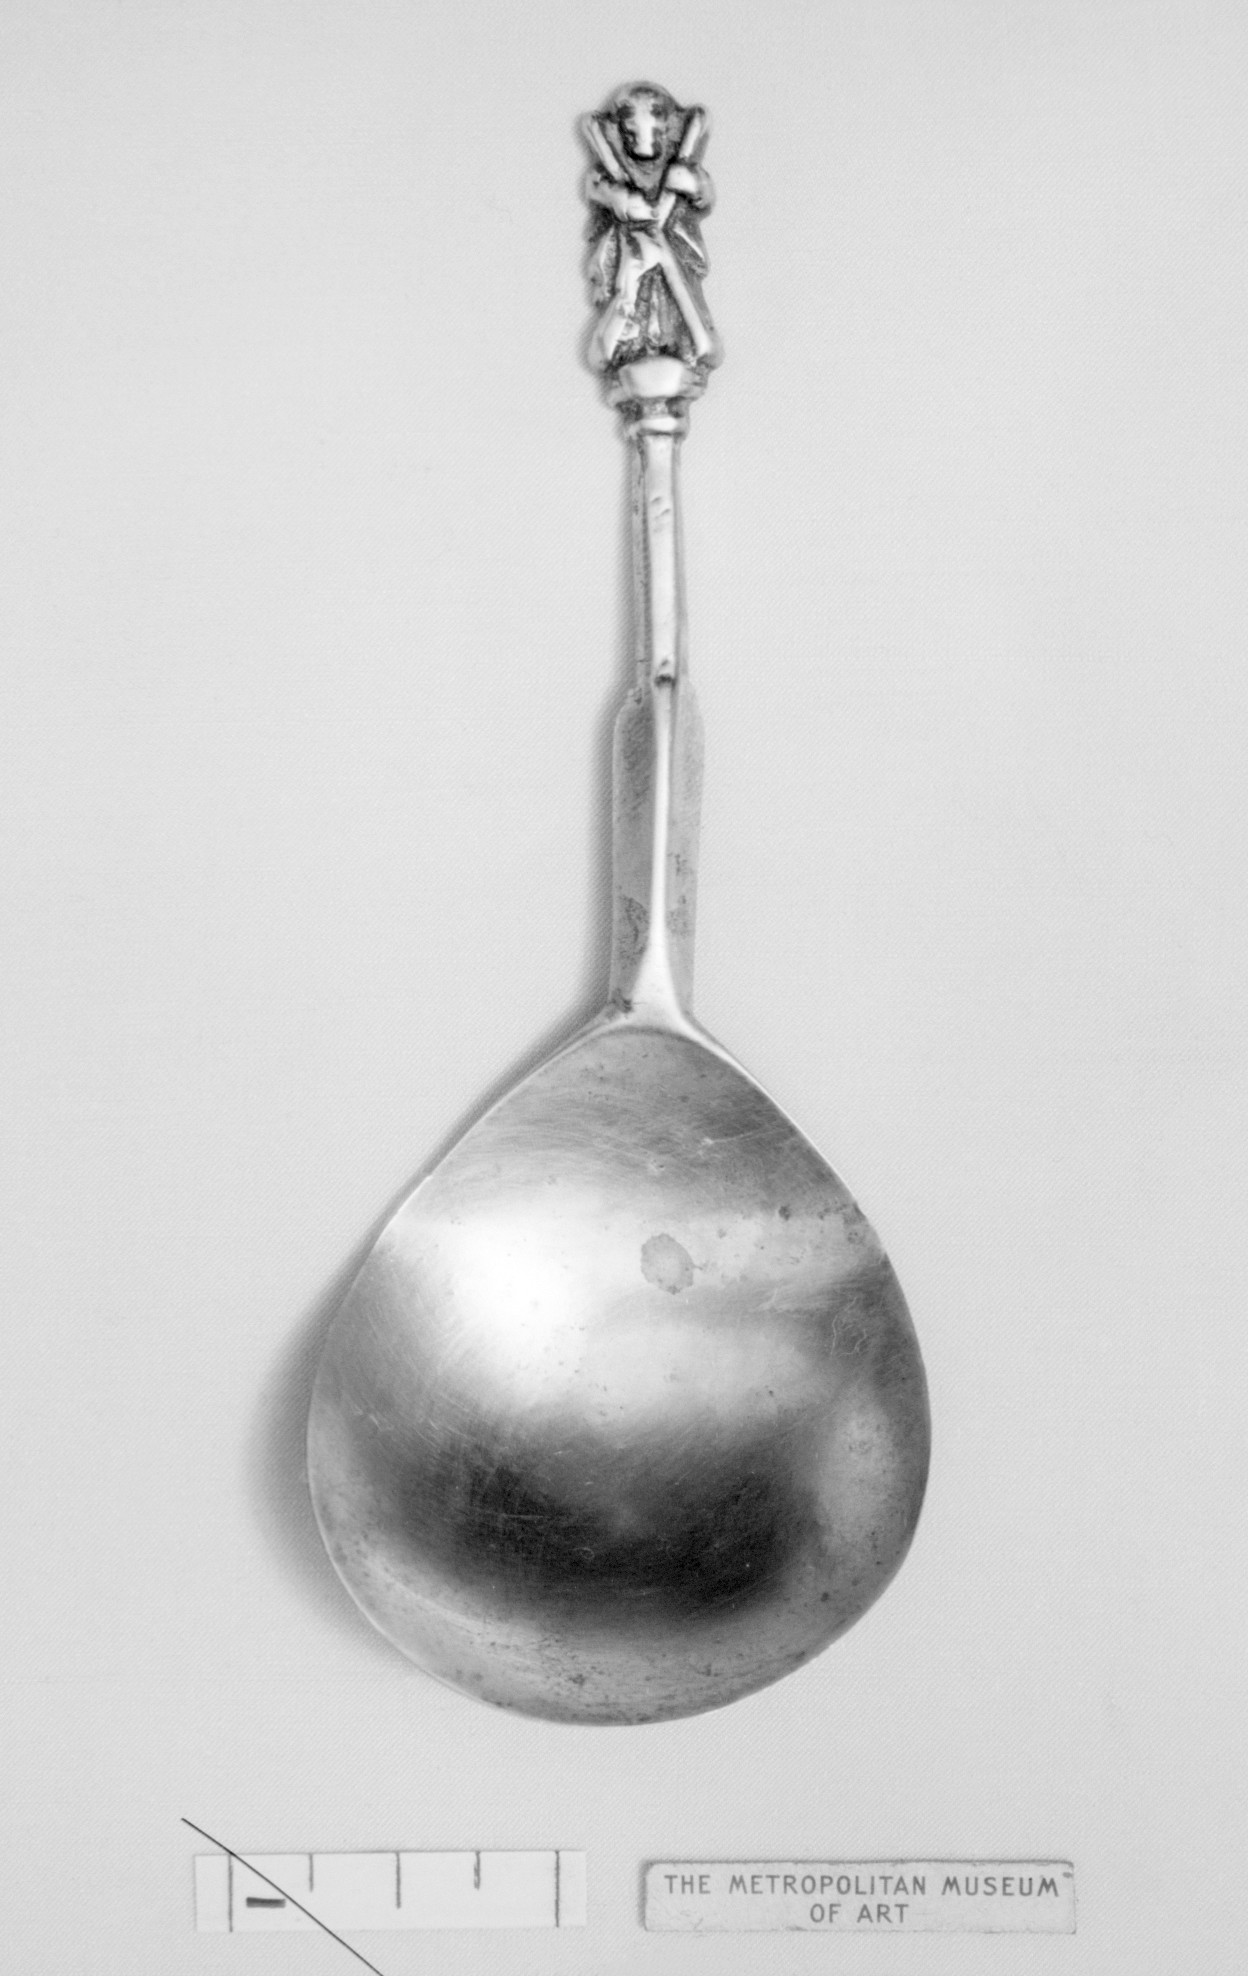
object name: apostle spoon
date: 1501-1600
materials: bronze, gilt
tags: apostles